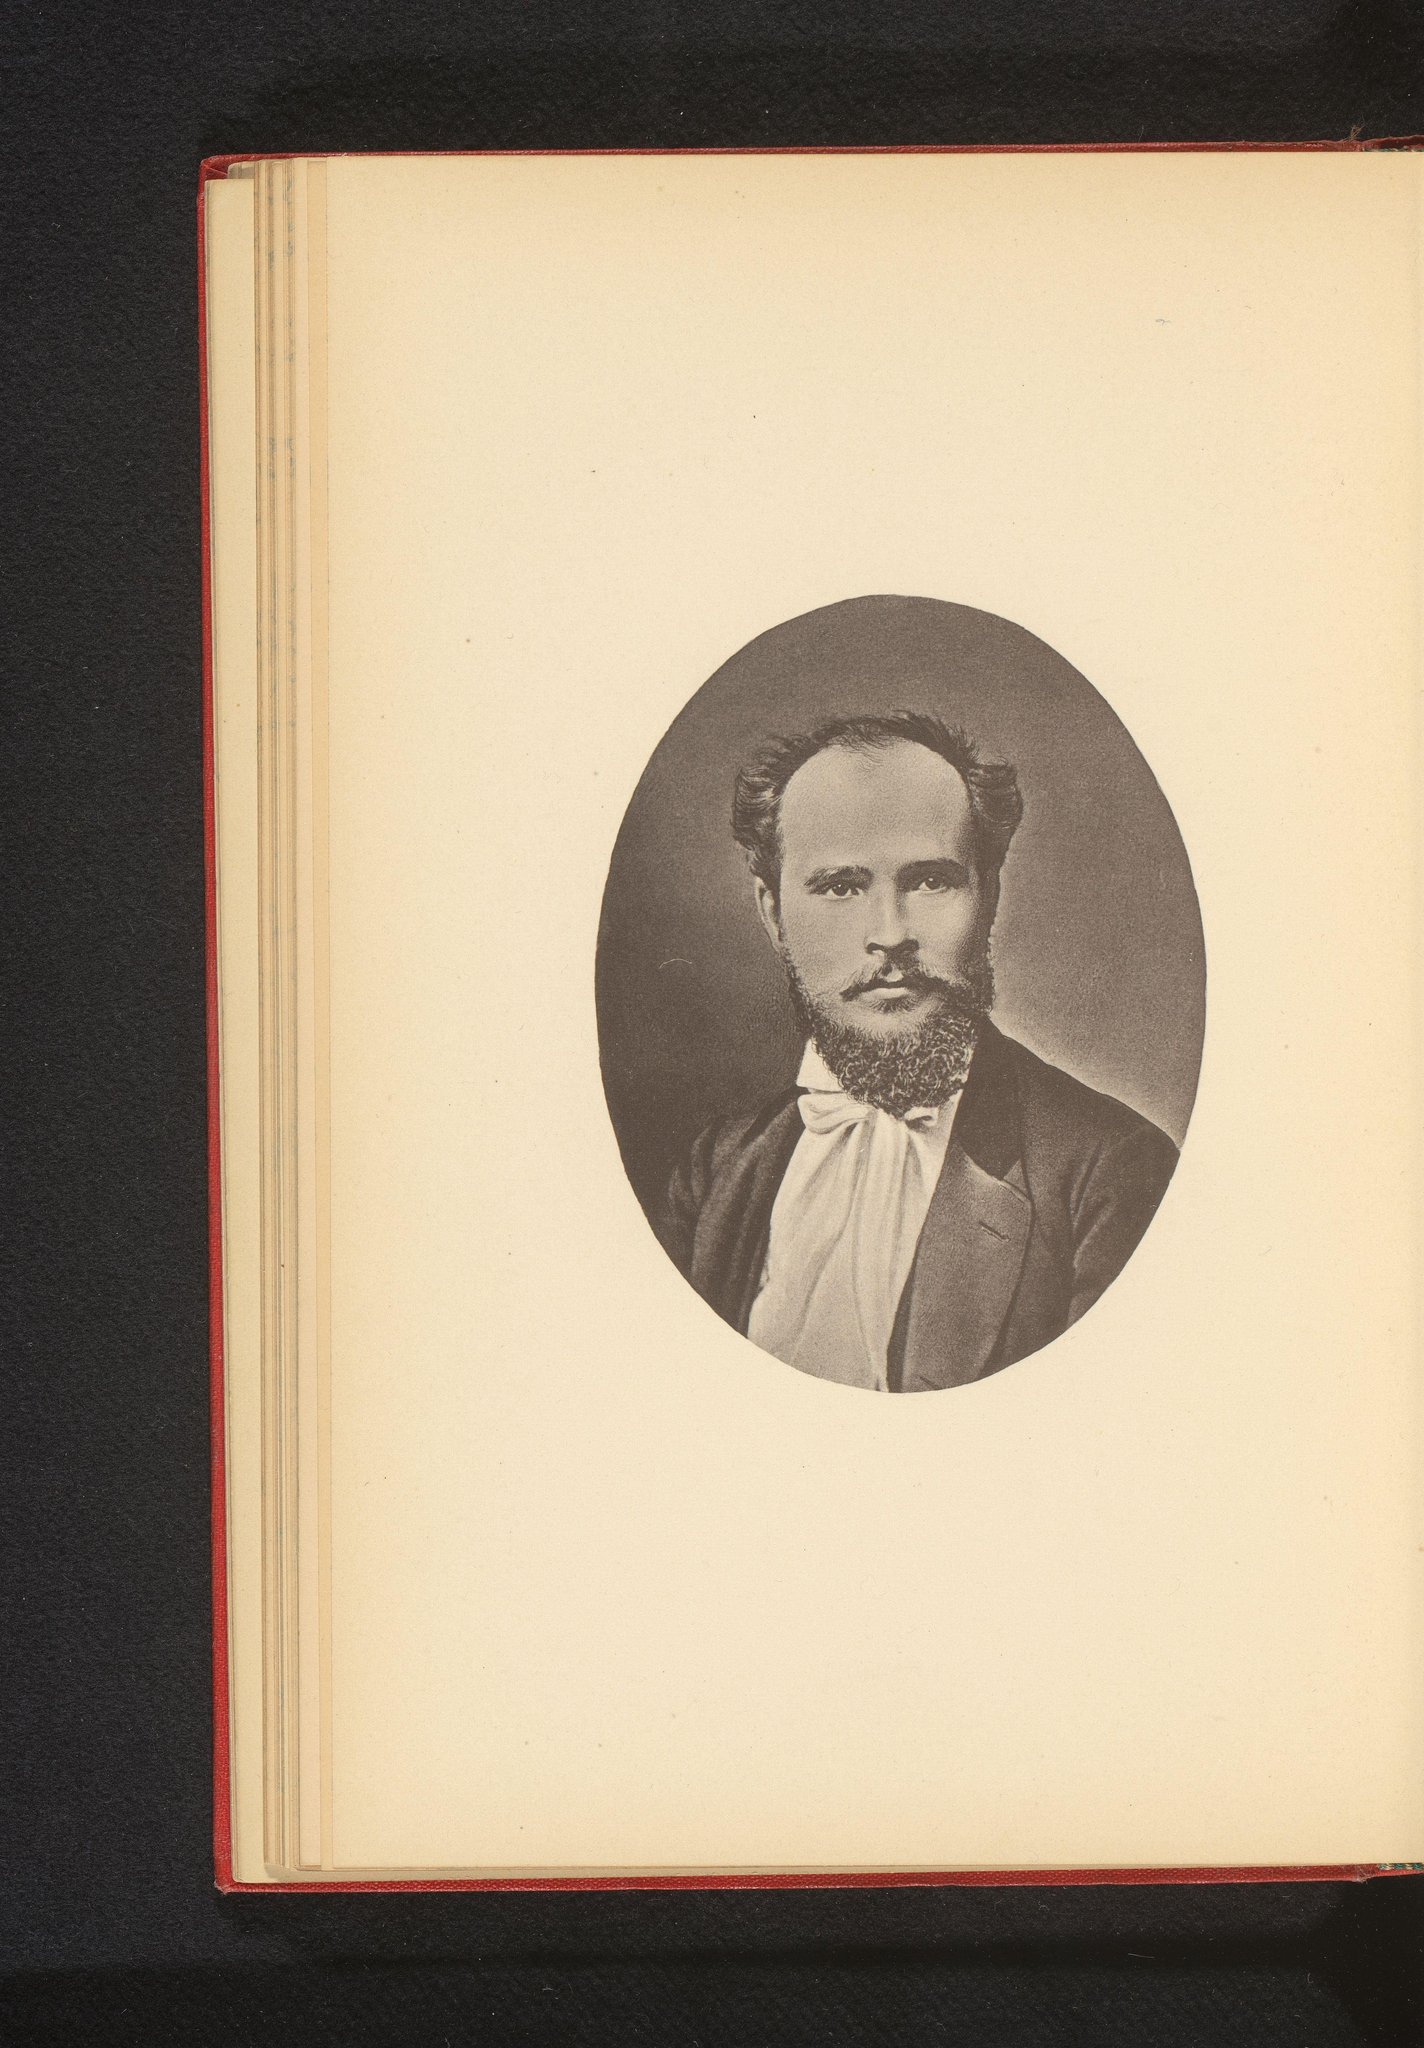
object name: page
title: Portret van Johannes Takanen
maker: Anonymous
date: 1873-1883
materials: paper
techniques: photograph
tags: sculptor, portrait, self-portrait of sculptor